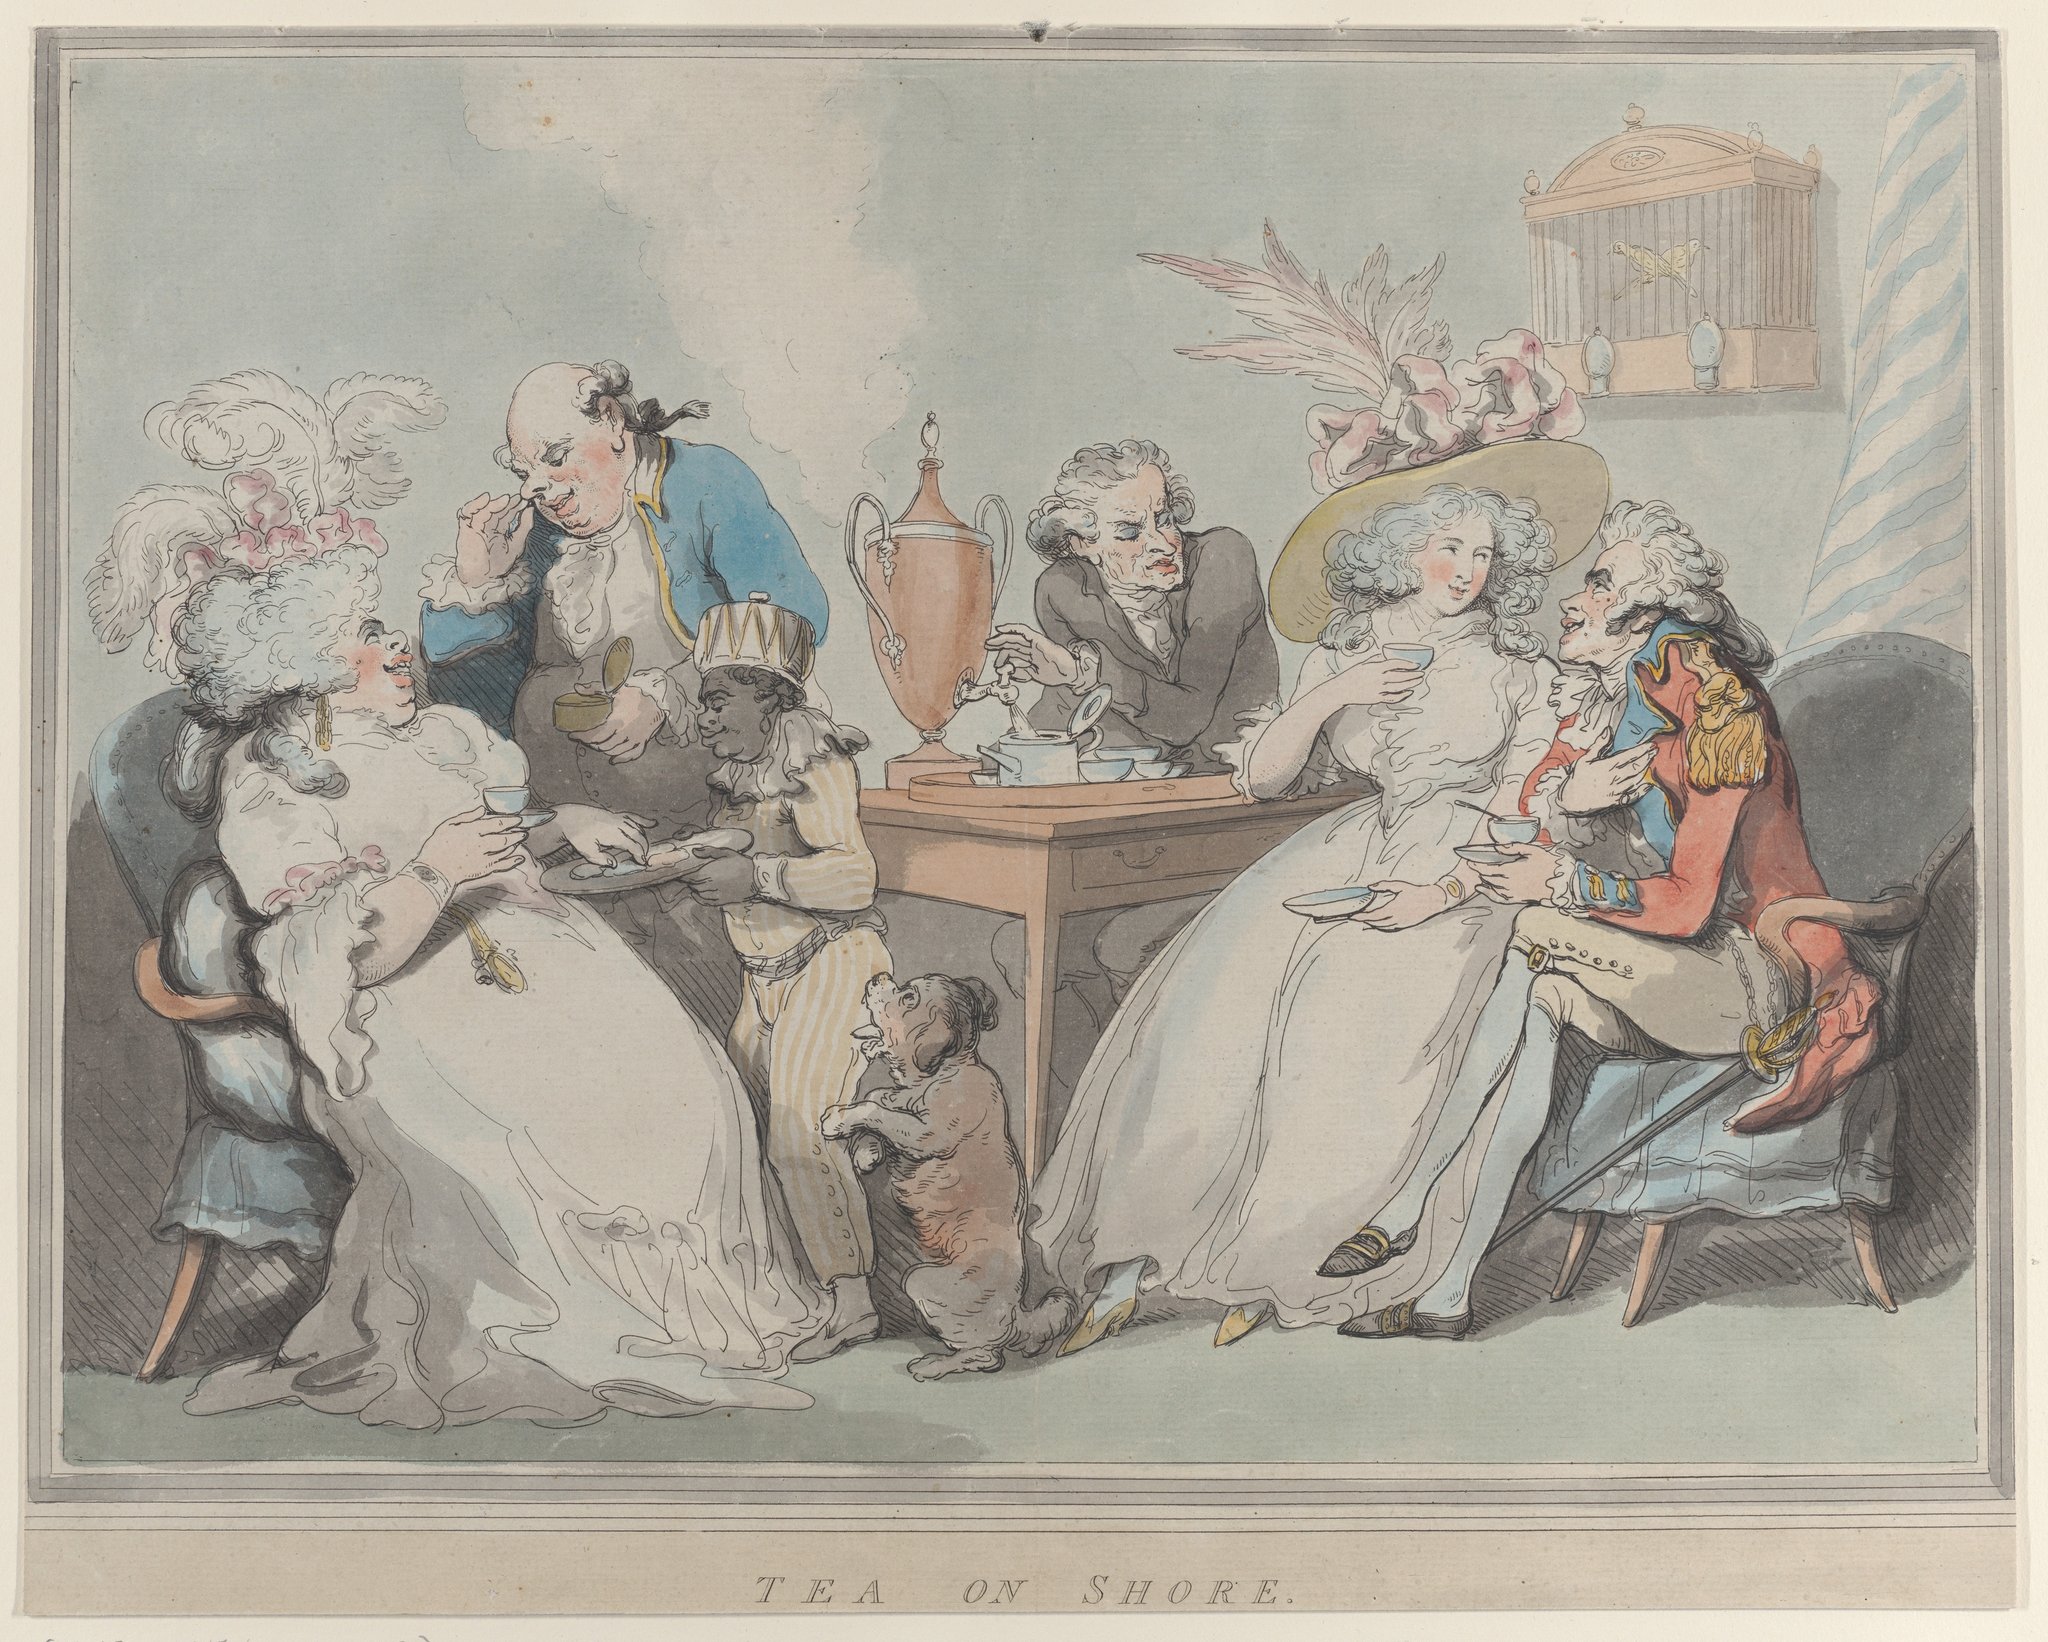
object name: print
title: Tea on Shore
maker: thomas rowlandson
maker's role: artist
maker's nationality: british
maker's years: 1757-1827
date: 1785-1794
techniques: aquatint, etching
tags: satire,men,women,dogs,drinking,tea